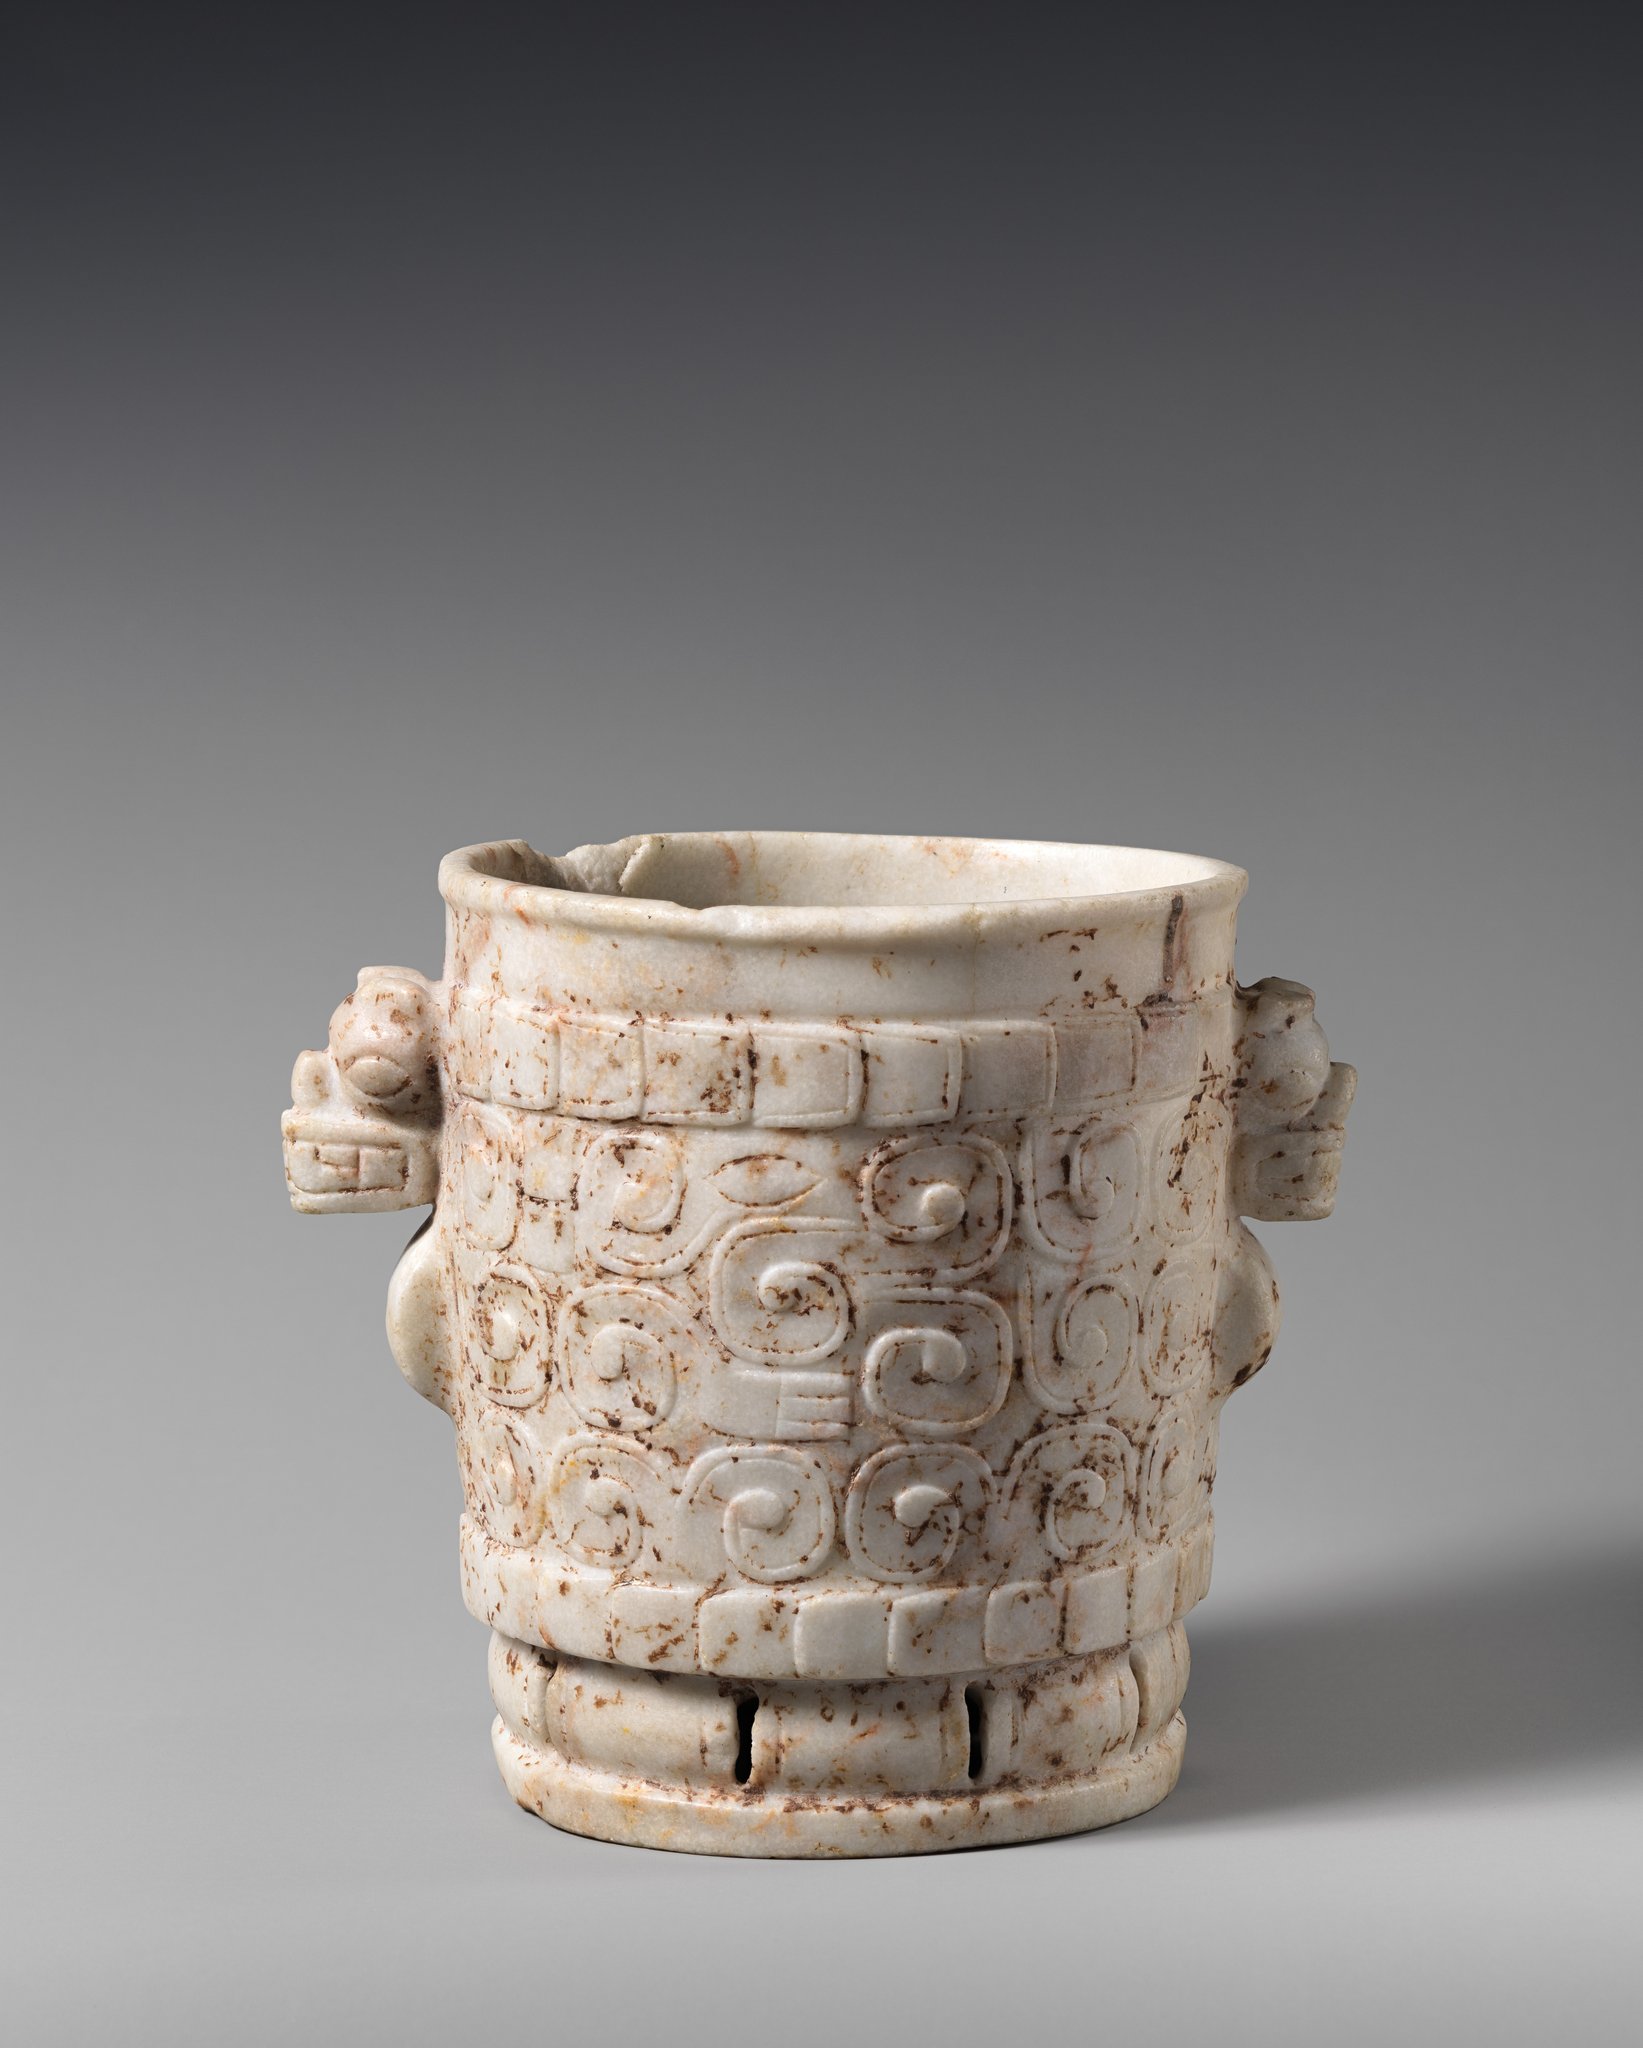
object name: bowl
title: Pedestal vessel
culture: ulúa valley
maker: ulúa valley artist(s)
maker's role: artist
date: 800-1000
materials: marble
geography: honduras